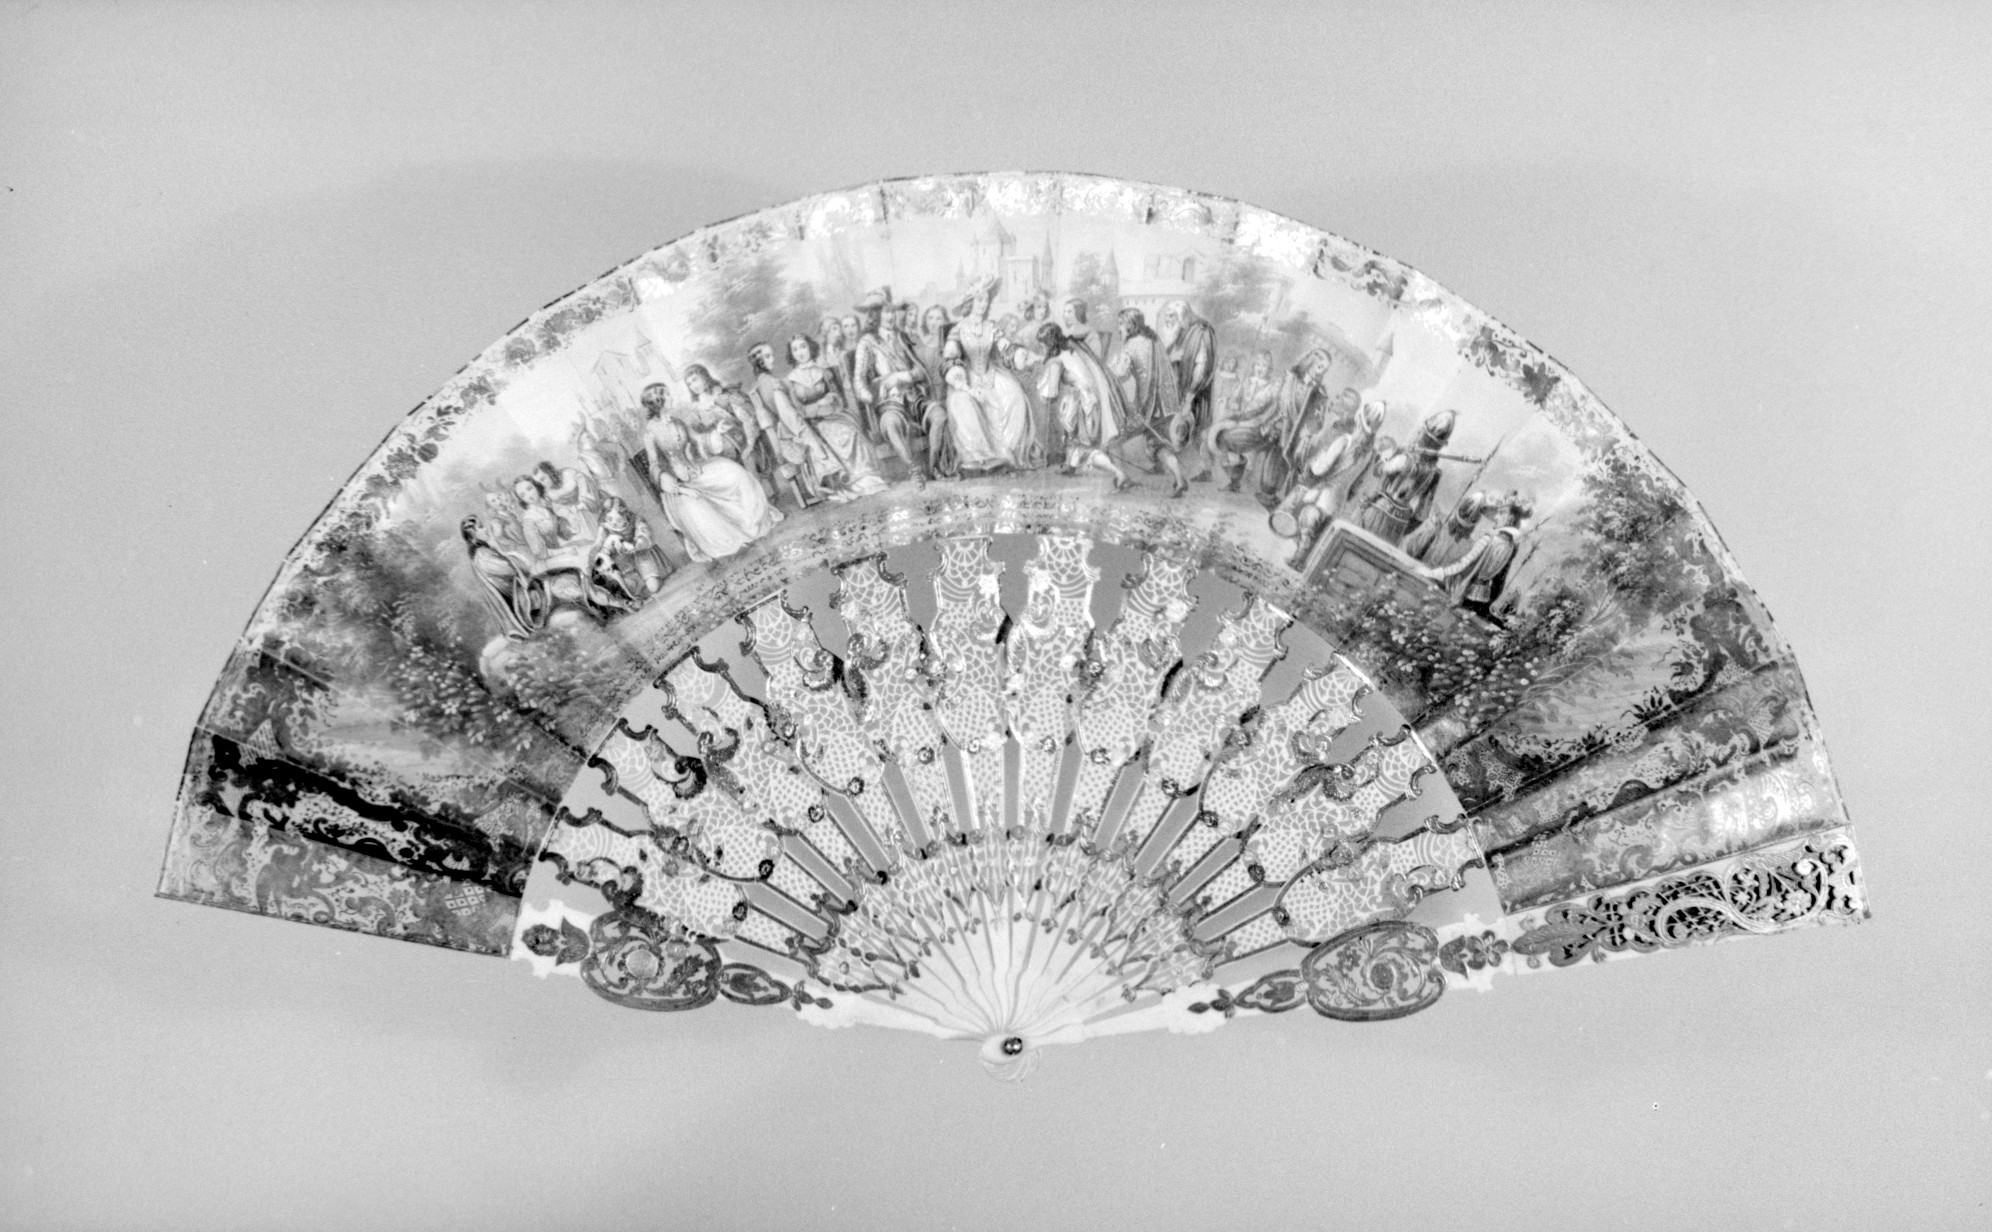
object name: fan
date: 1834-1866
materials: gilt, glass, ivory, paint, paper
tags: men,women,dogs